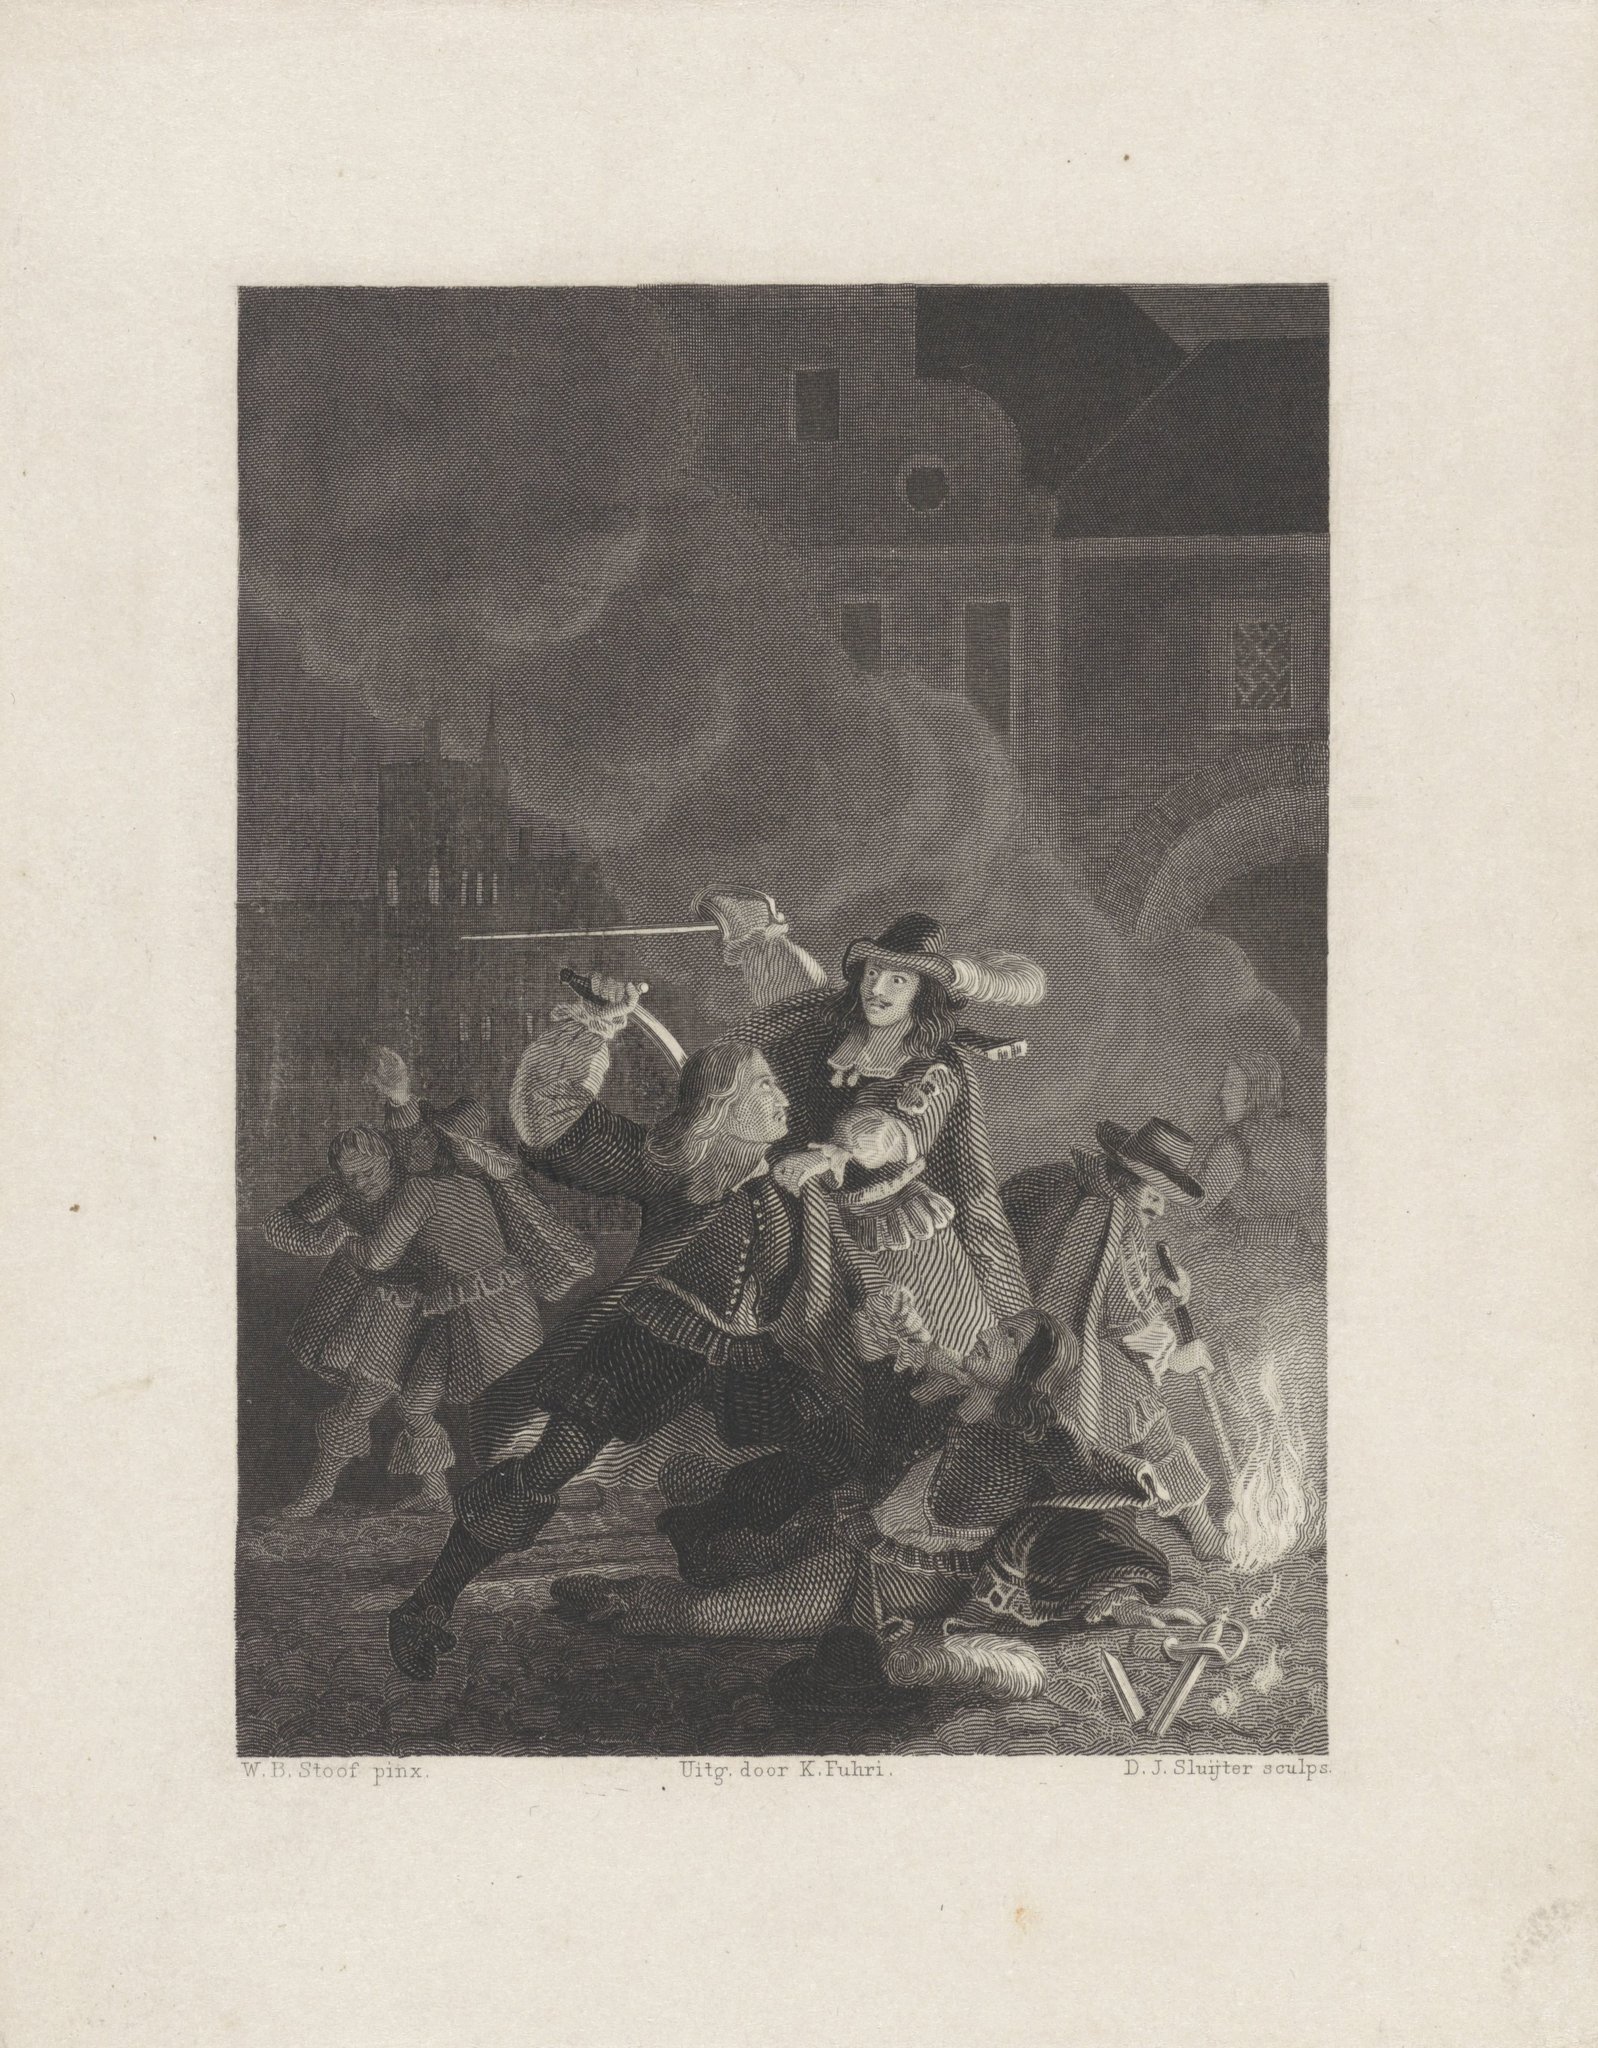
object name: book illustration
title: Schermutseling op straat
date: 1844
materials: paper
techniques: engraving, etching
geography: the hague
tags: drunkard, street-fights, riots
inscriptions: collector's mark: Lugt 2228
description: Op straat slaan twee rijkgeklede mannen op elkaar in met hun degens. Een derde man zit op straat; zijn gebroken degen ligt naast hem. Daarachter port een man met een stok in een vuurtje. Op de achtergrond ondersteunt een man een dronkaard. Illustratie bij het verhaal "Van God verlaten (1672)" door J.I.D. Nepveu.